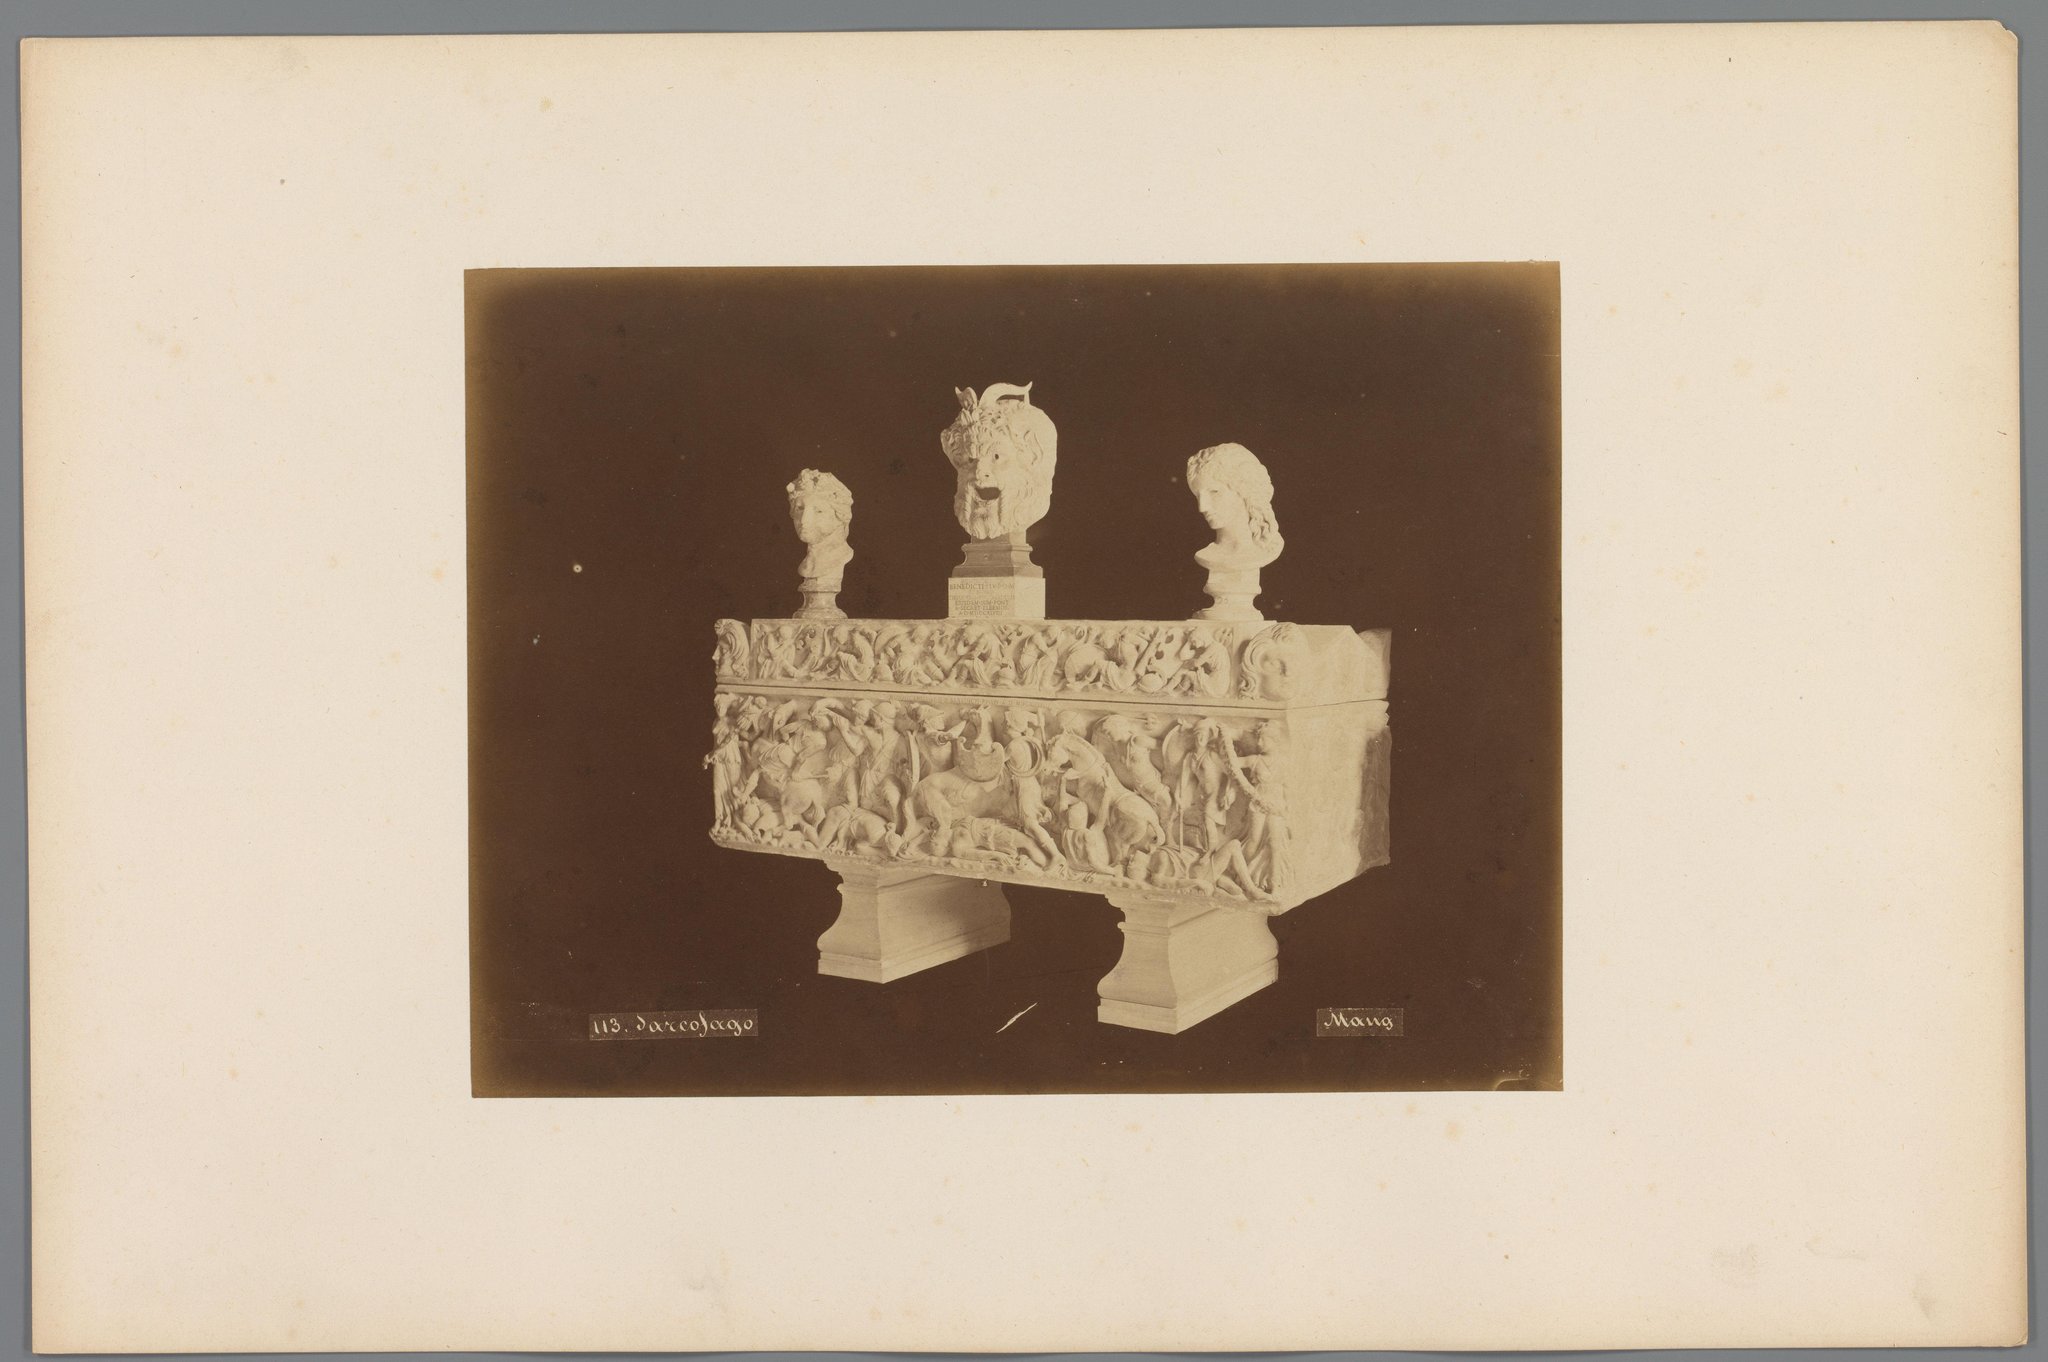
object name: photograph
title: Sarcofago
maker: michèle mang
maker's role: fotograaf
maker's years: 1840-1909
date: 1863-1887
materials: cardboard, paper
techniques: albumen print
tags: satyrs, fauns, sileni, sarcophagus, art (+ relief ~ sculpture)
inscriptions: number: ‘113.’